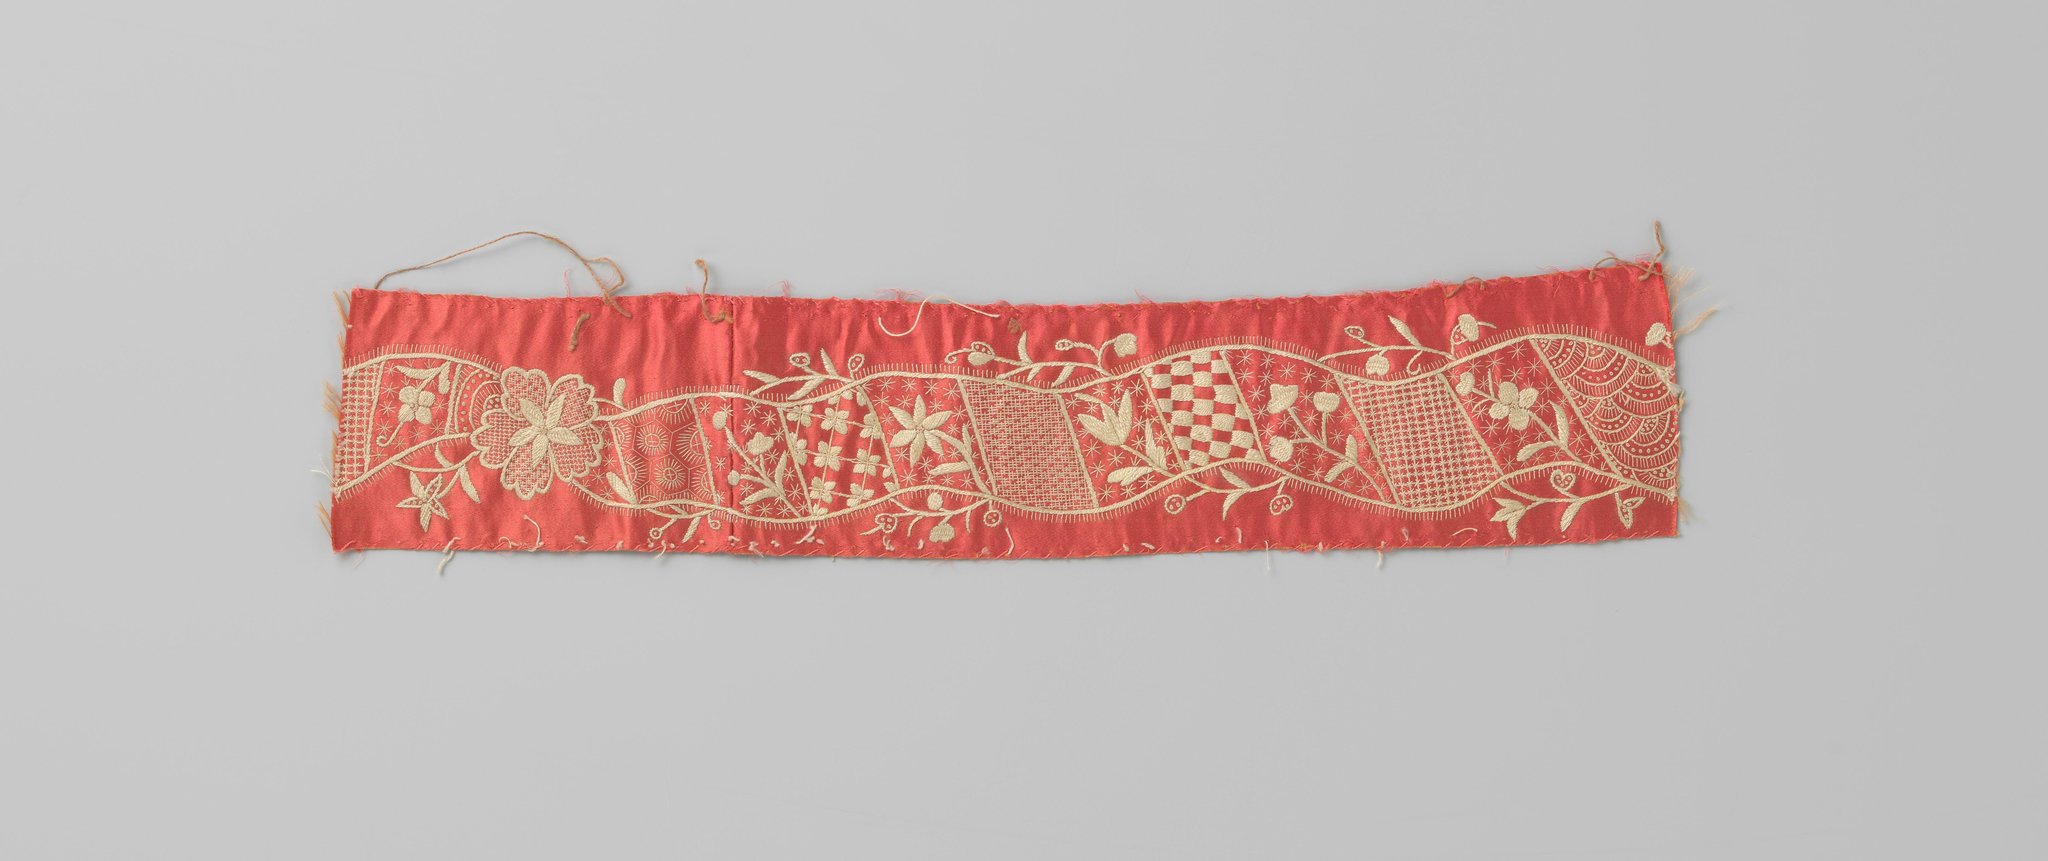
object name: strip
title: Embroidered Interior Textile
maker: Anonymous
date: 1750-1760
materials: silk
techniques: embroidered, weave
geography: france